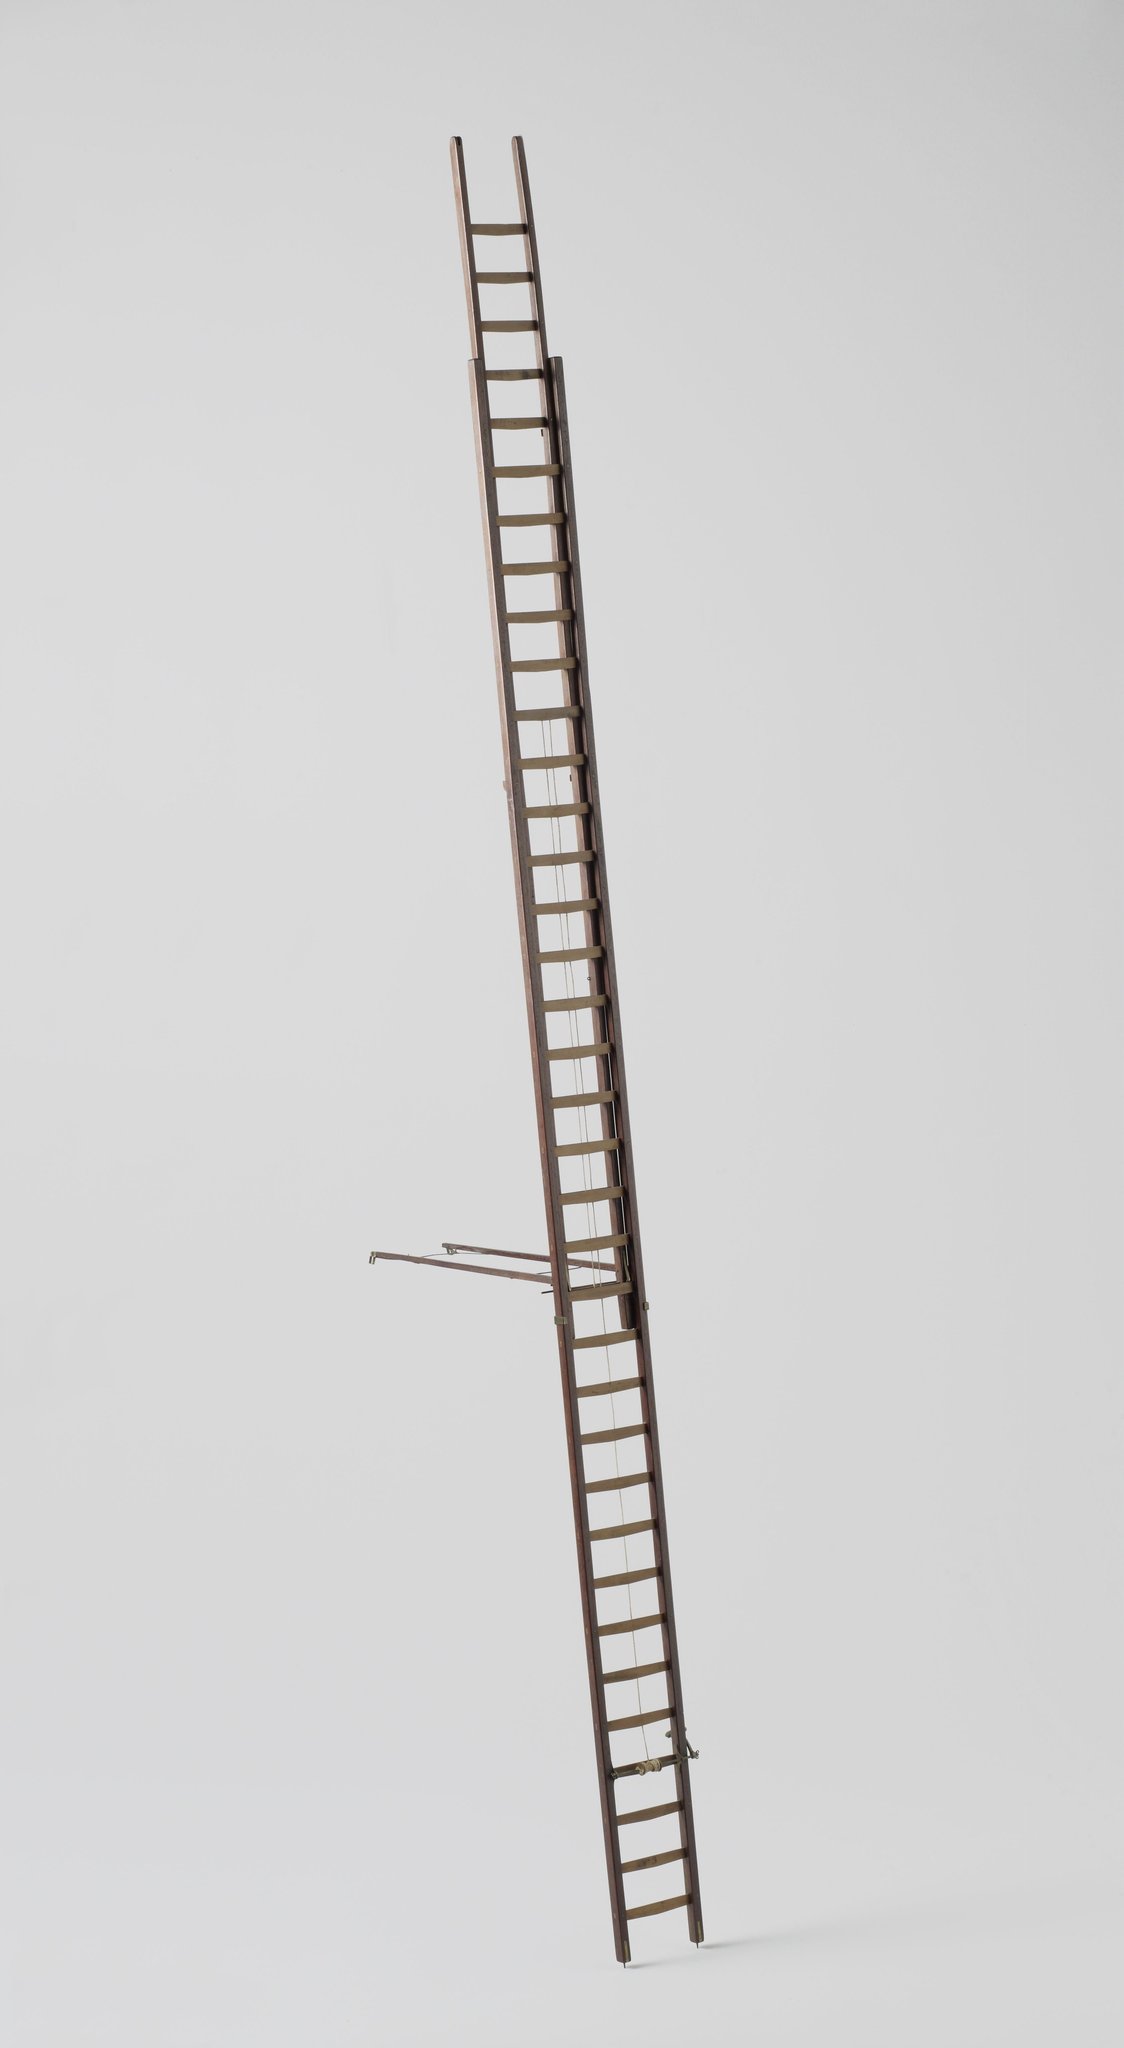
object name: demonstration model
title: Model of a Ladder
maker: petrus van der loo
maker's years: 1806-1864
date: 1850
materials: brass, wood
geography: the hague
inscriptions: inscription, on a rung: ‘No 3’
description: Model van tweedelige ladder. Het uitschuifbare gedeelte heeft een wieltje bovenaan iedere poot en wordt met een zwengel en windas onder aan het onderdeel uitgeschoven: het touw hiervan loopt over een schijf in een der bovenste sporten van het onderdeel naar de onderste sport van het uitschuifbare gedeelte. Twee pallen beletten het terugschuiven. Het uitschuifbare gedeelte is ook uitgerust met een zwieping, die als tussensteun en als uithouder dient. De zwieping valt op een bepaalde hoogte automatisch uit; de zwieping is incompleet.